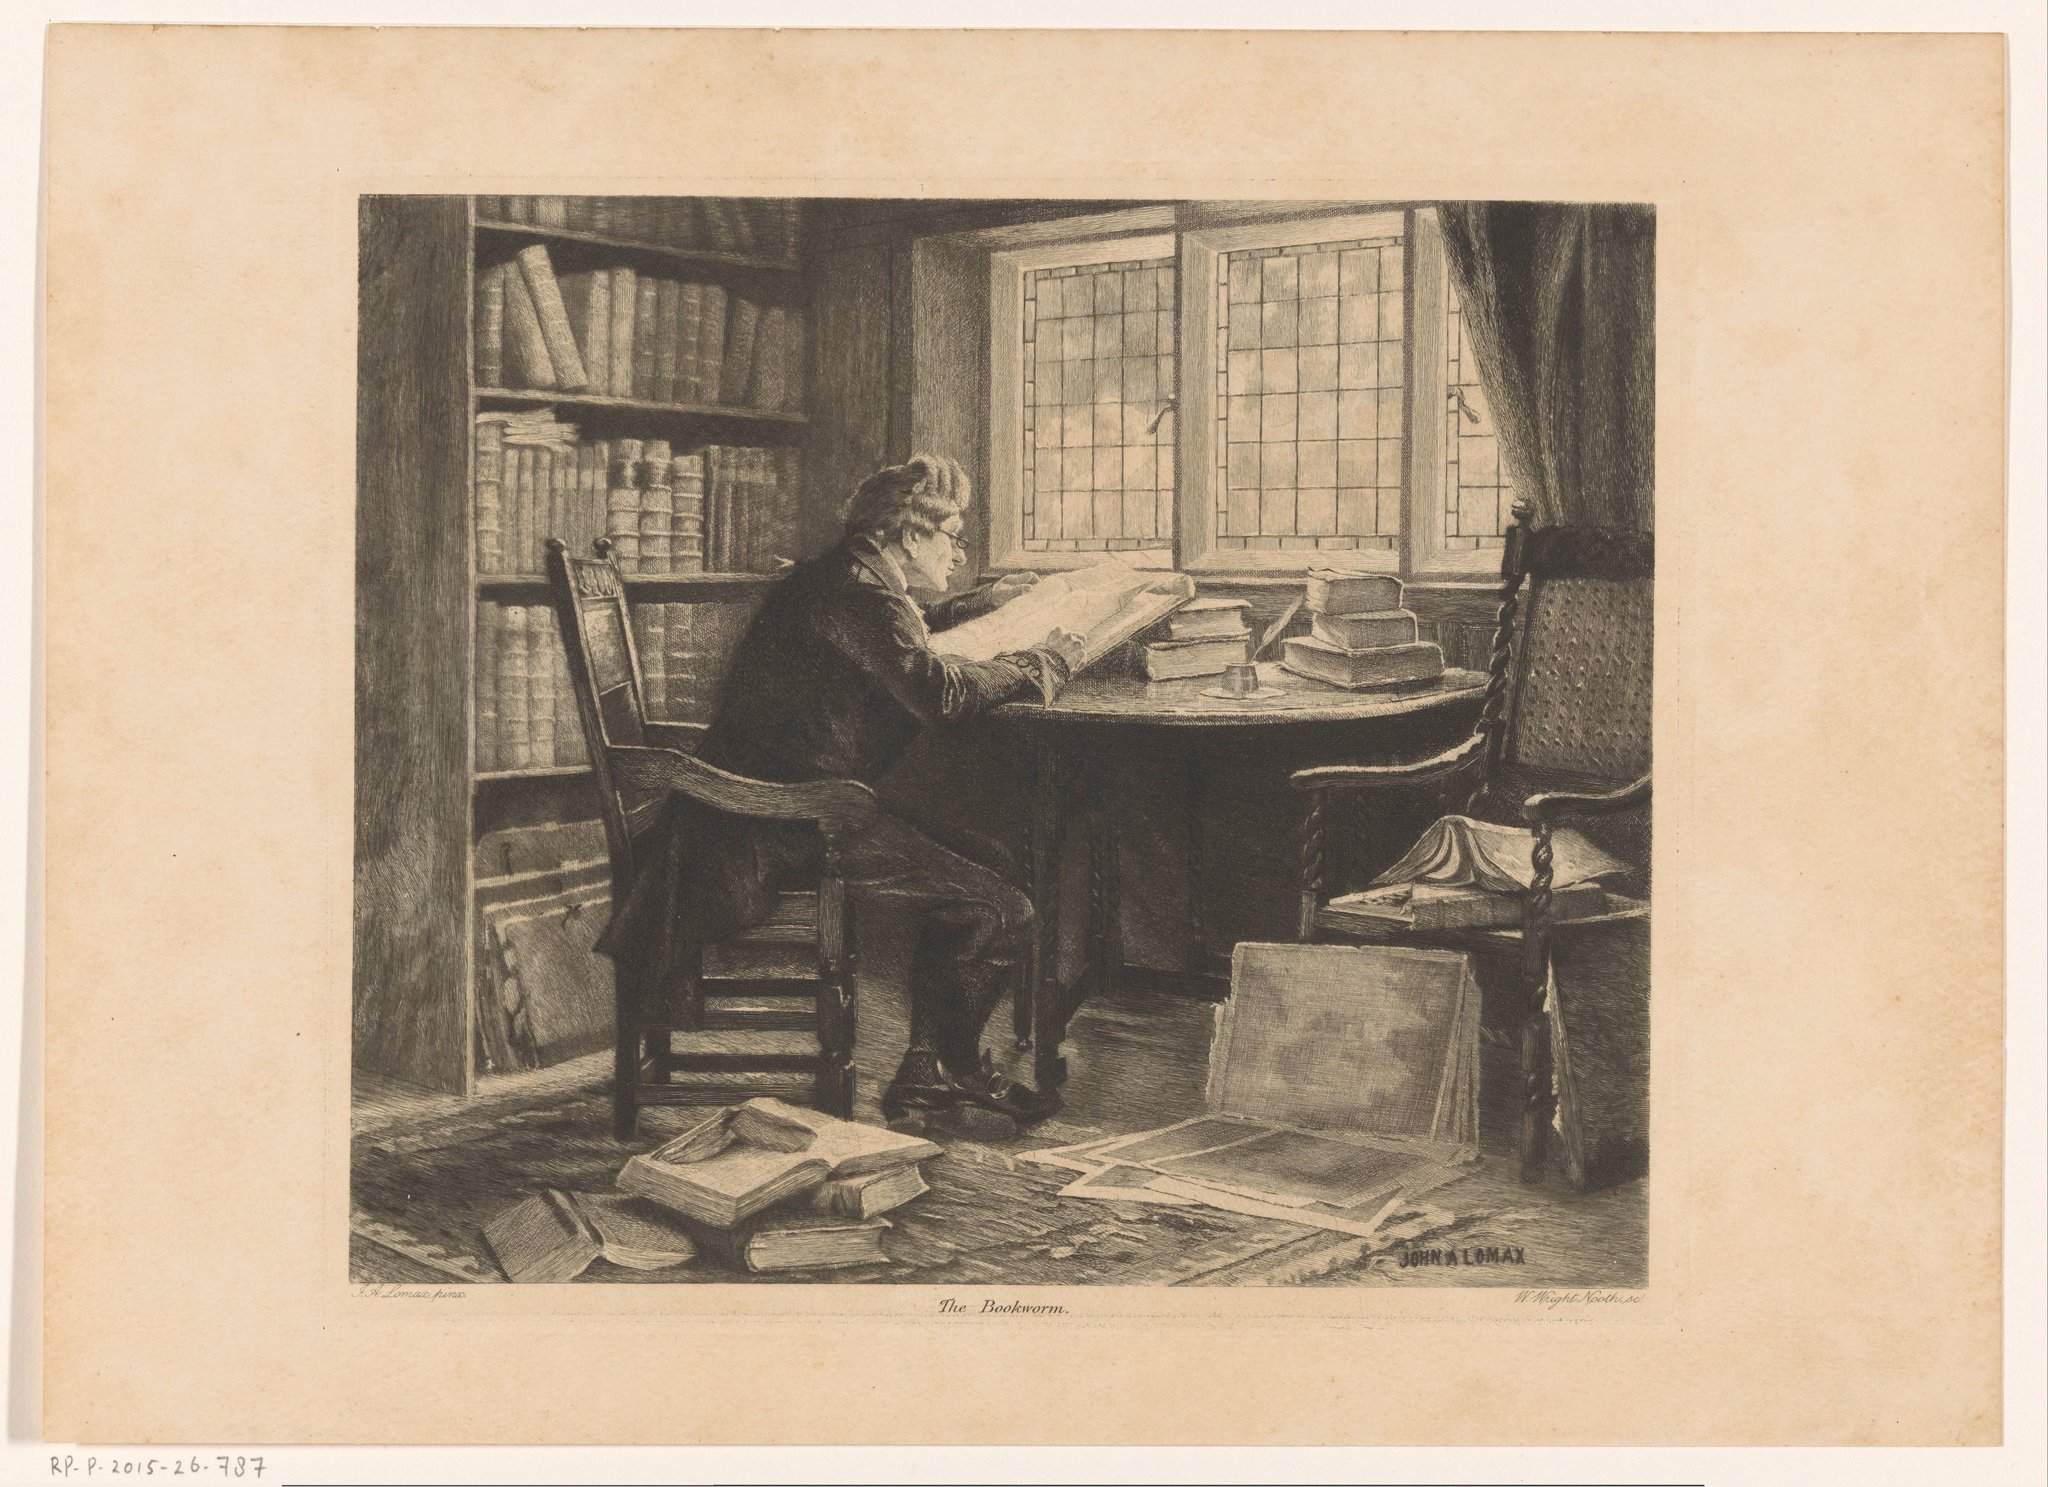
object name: print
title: Lezende man voor het raam van zijn studeervertrek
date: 1892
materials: paper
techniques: drypoint, etching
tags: bookshelves, study; 'studiolo'; library, book, newspaper, news-sheet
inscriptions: collector's mark: Lugt 4779, collector's mark: Lugt 4780, collector's mark: Lugt 2228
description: Prent mogelijk gepubliceerd in: The Portfolio: an Artistic Periodical, dl. 23, 1892.